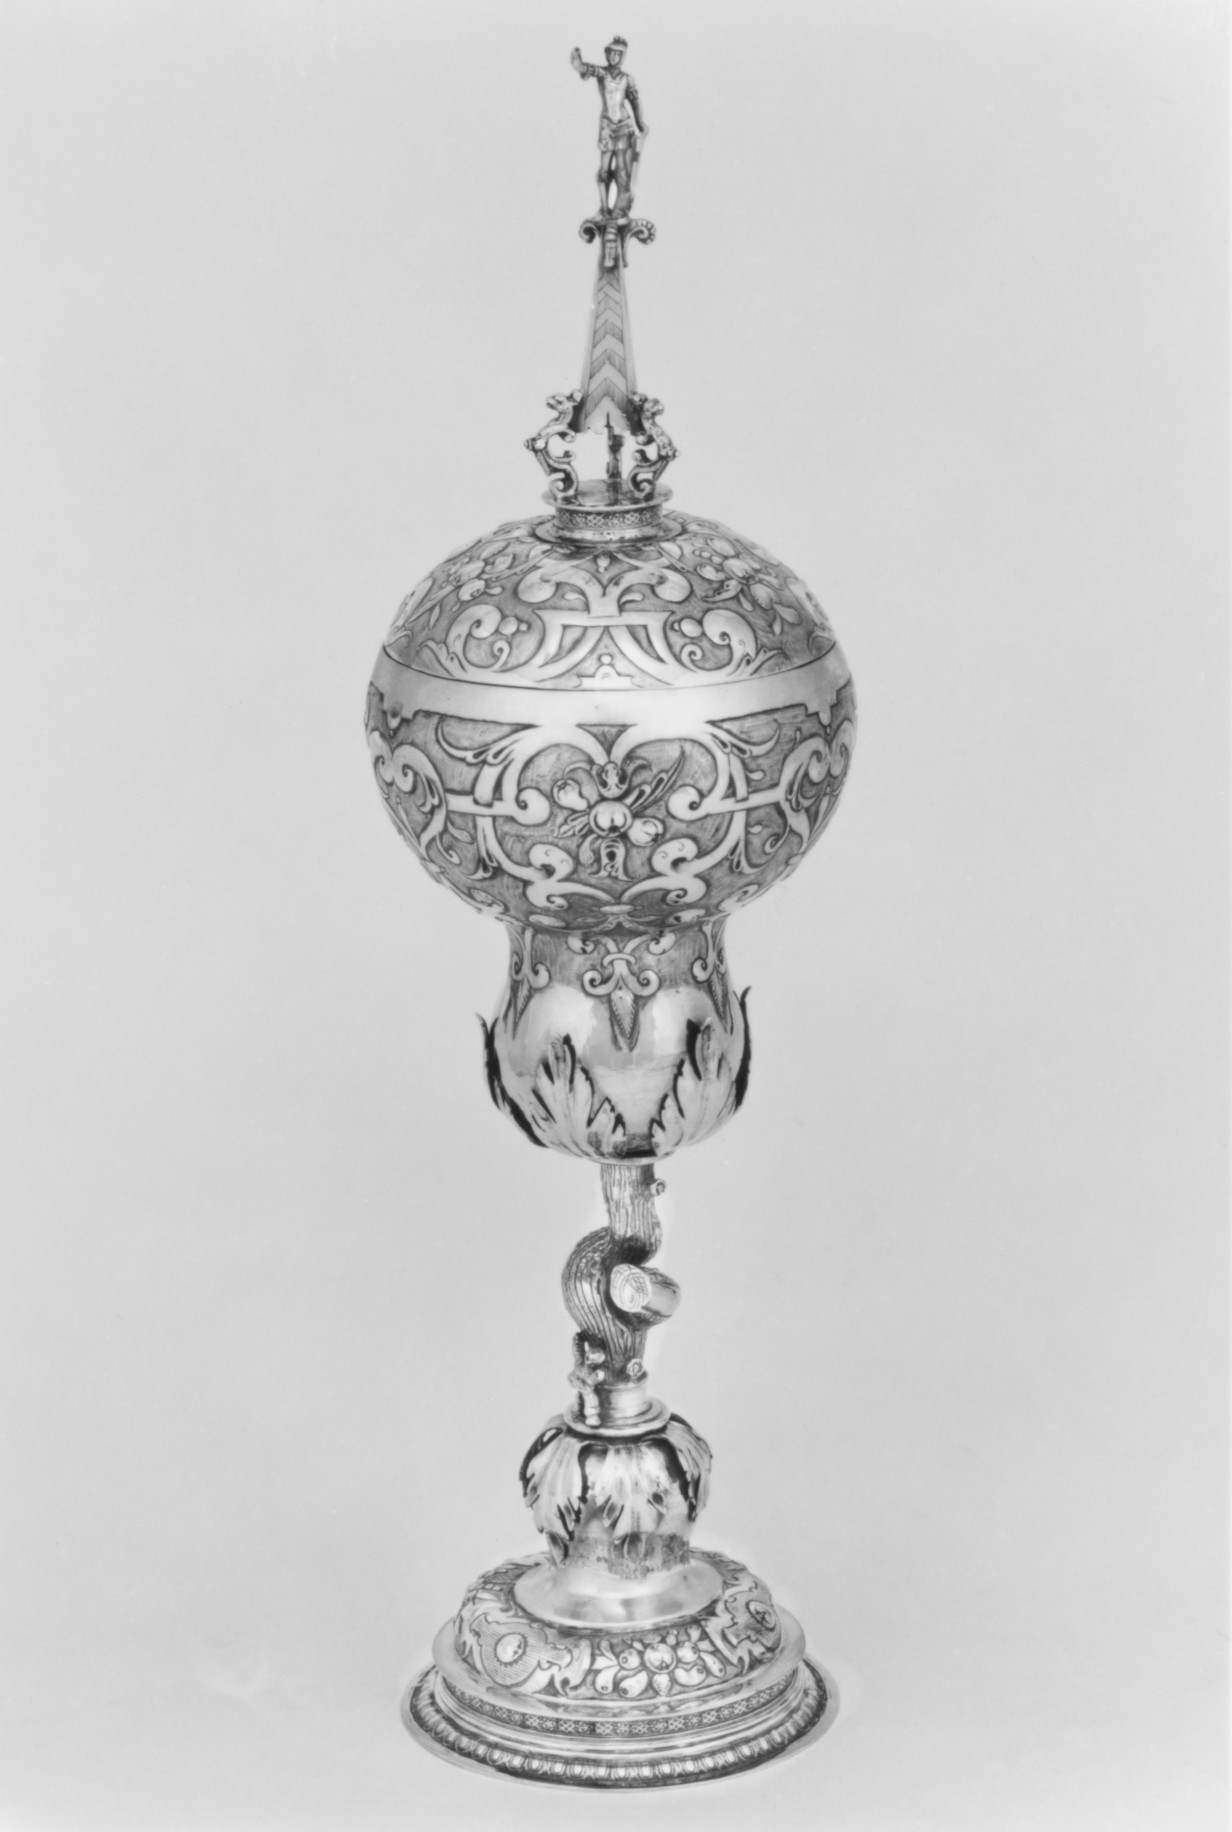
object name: steeple cup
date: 1608-1609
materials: silver gilt